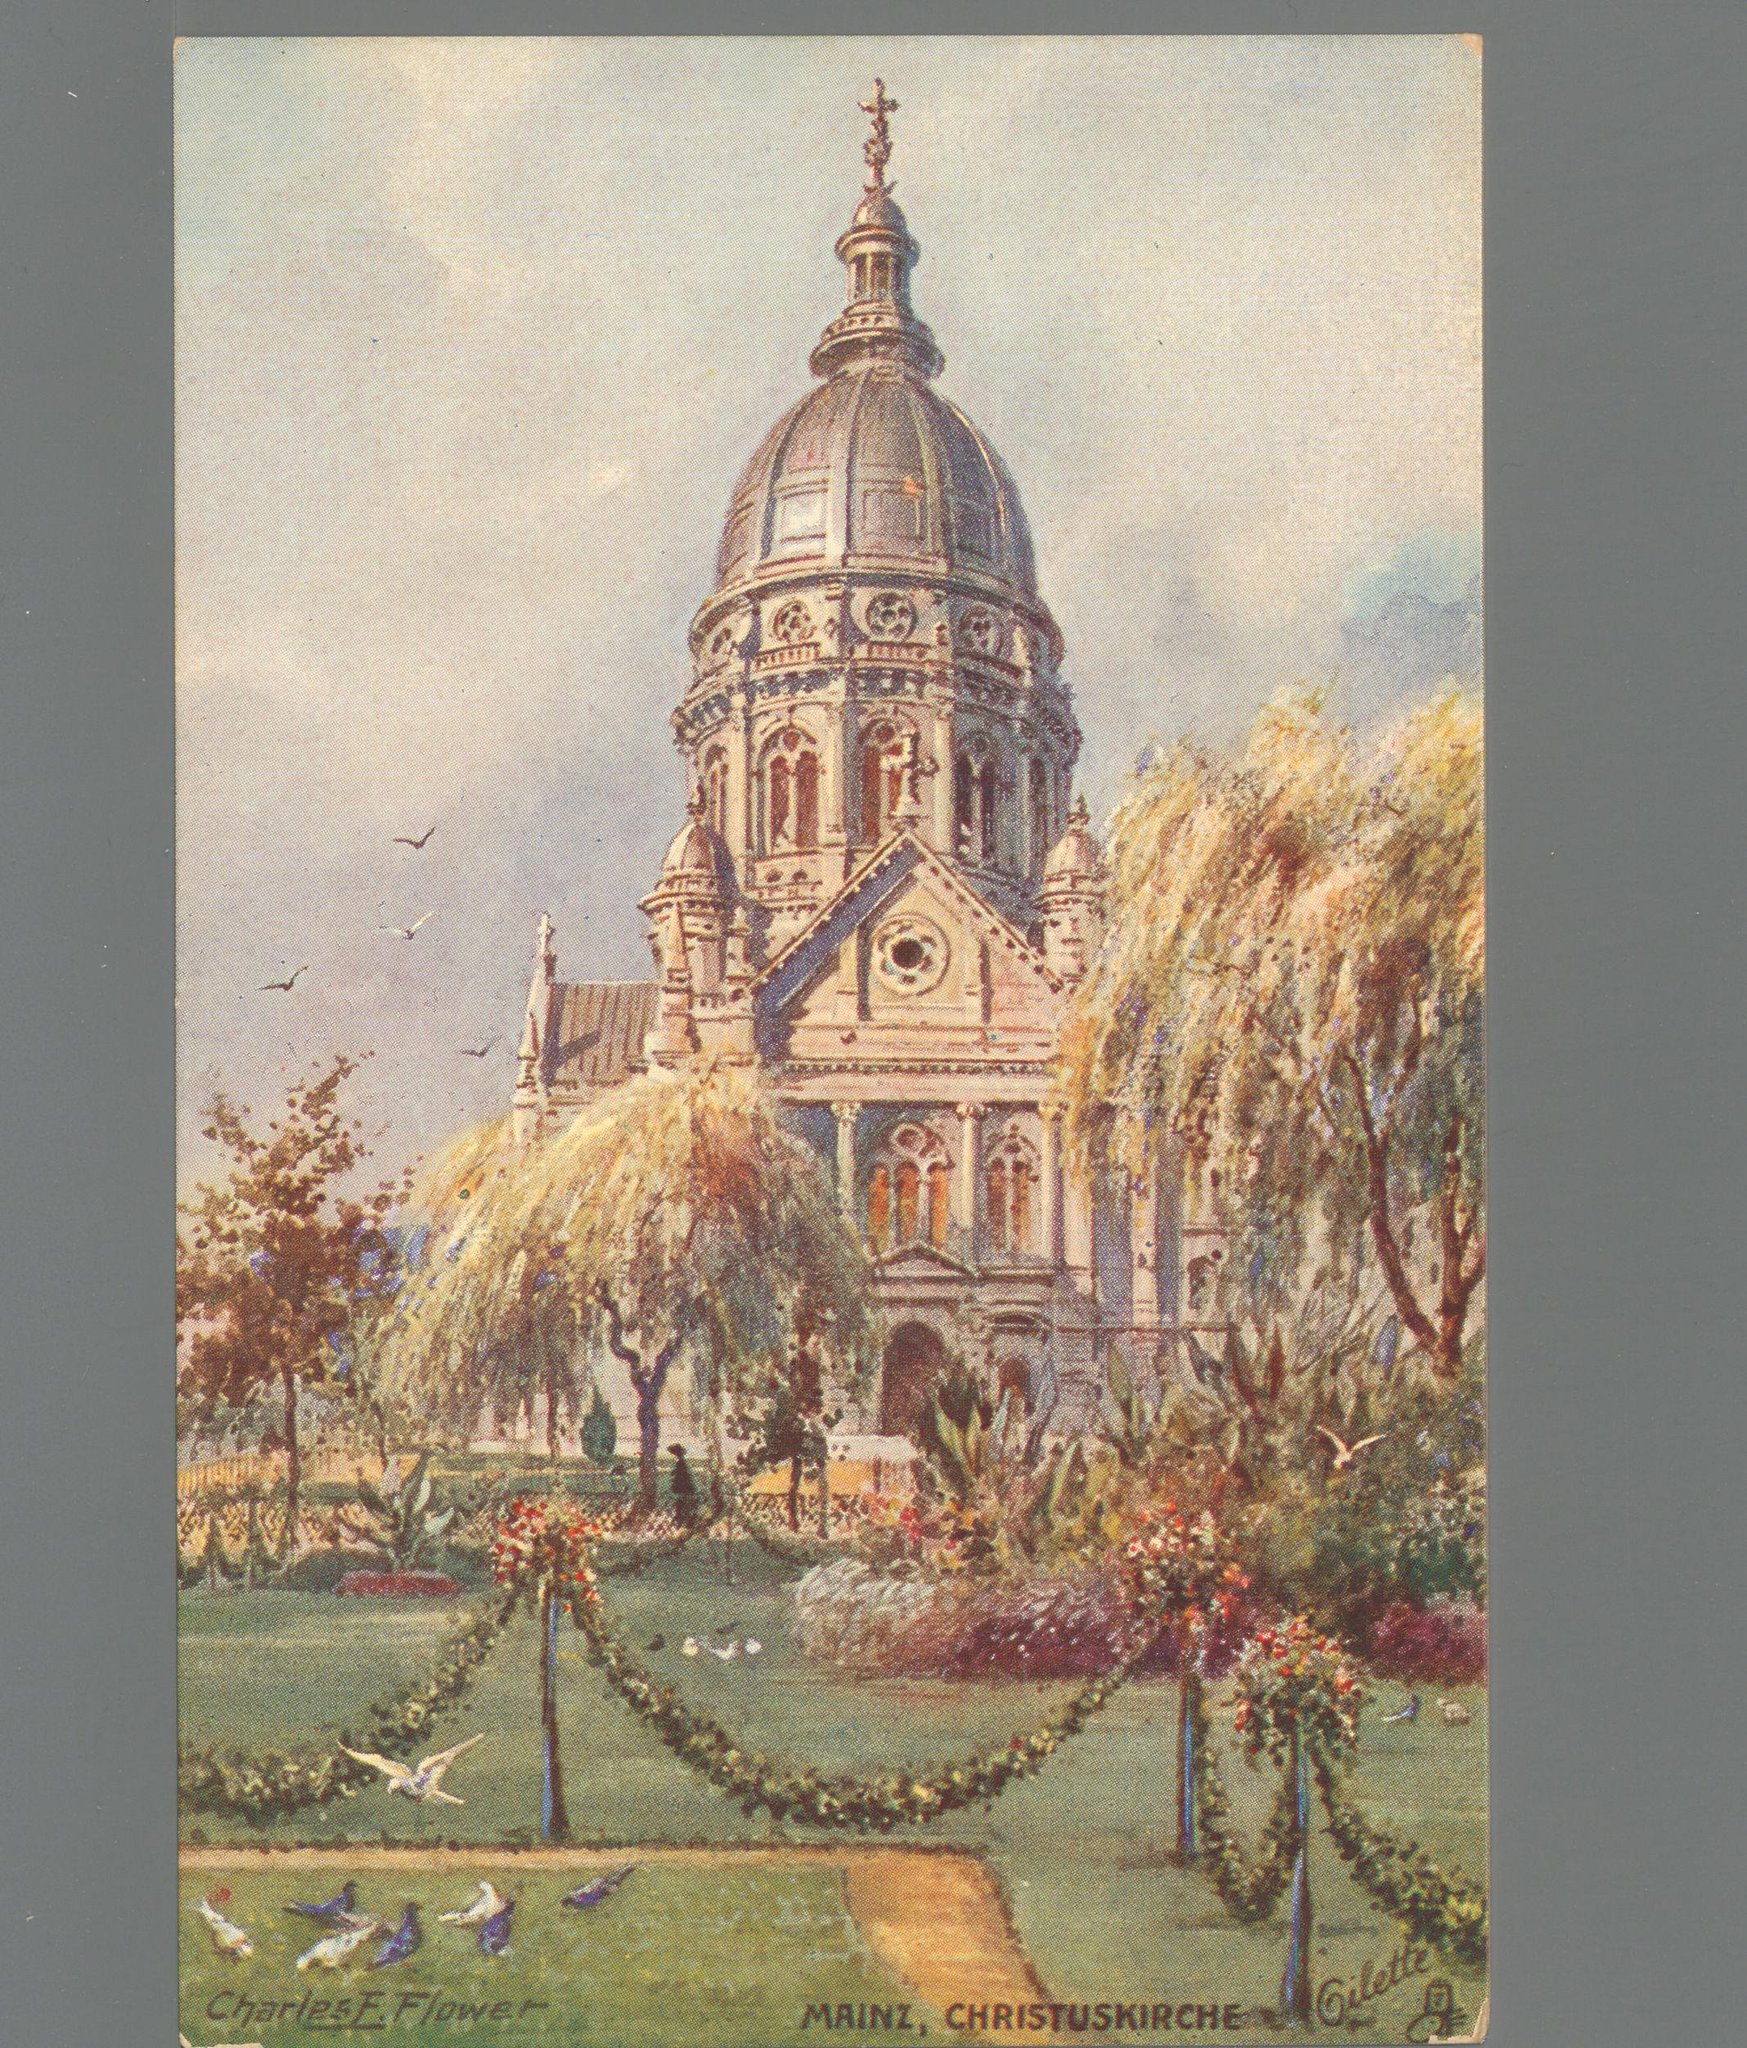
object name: ansichtkaart, prentbriefkaart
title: Oilette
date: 1905-1908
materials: cardboard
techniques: writing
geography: berlin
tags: church (exterior)